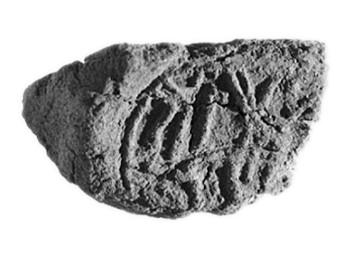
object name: sealing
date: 1981-1640 BCE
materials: mud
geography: egypt